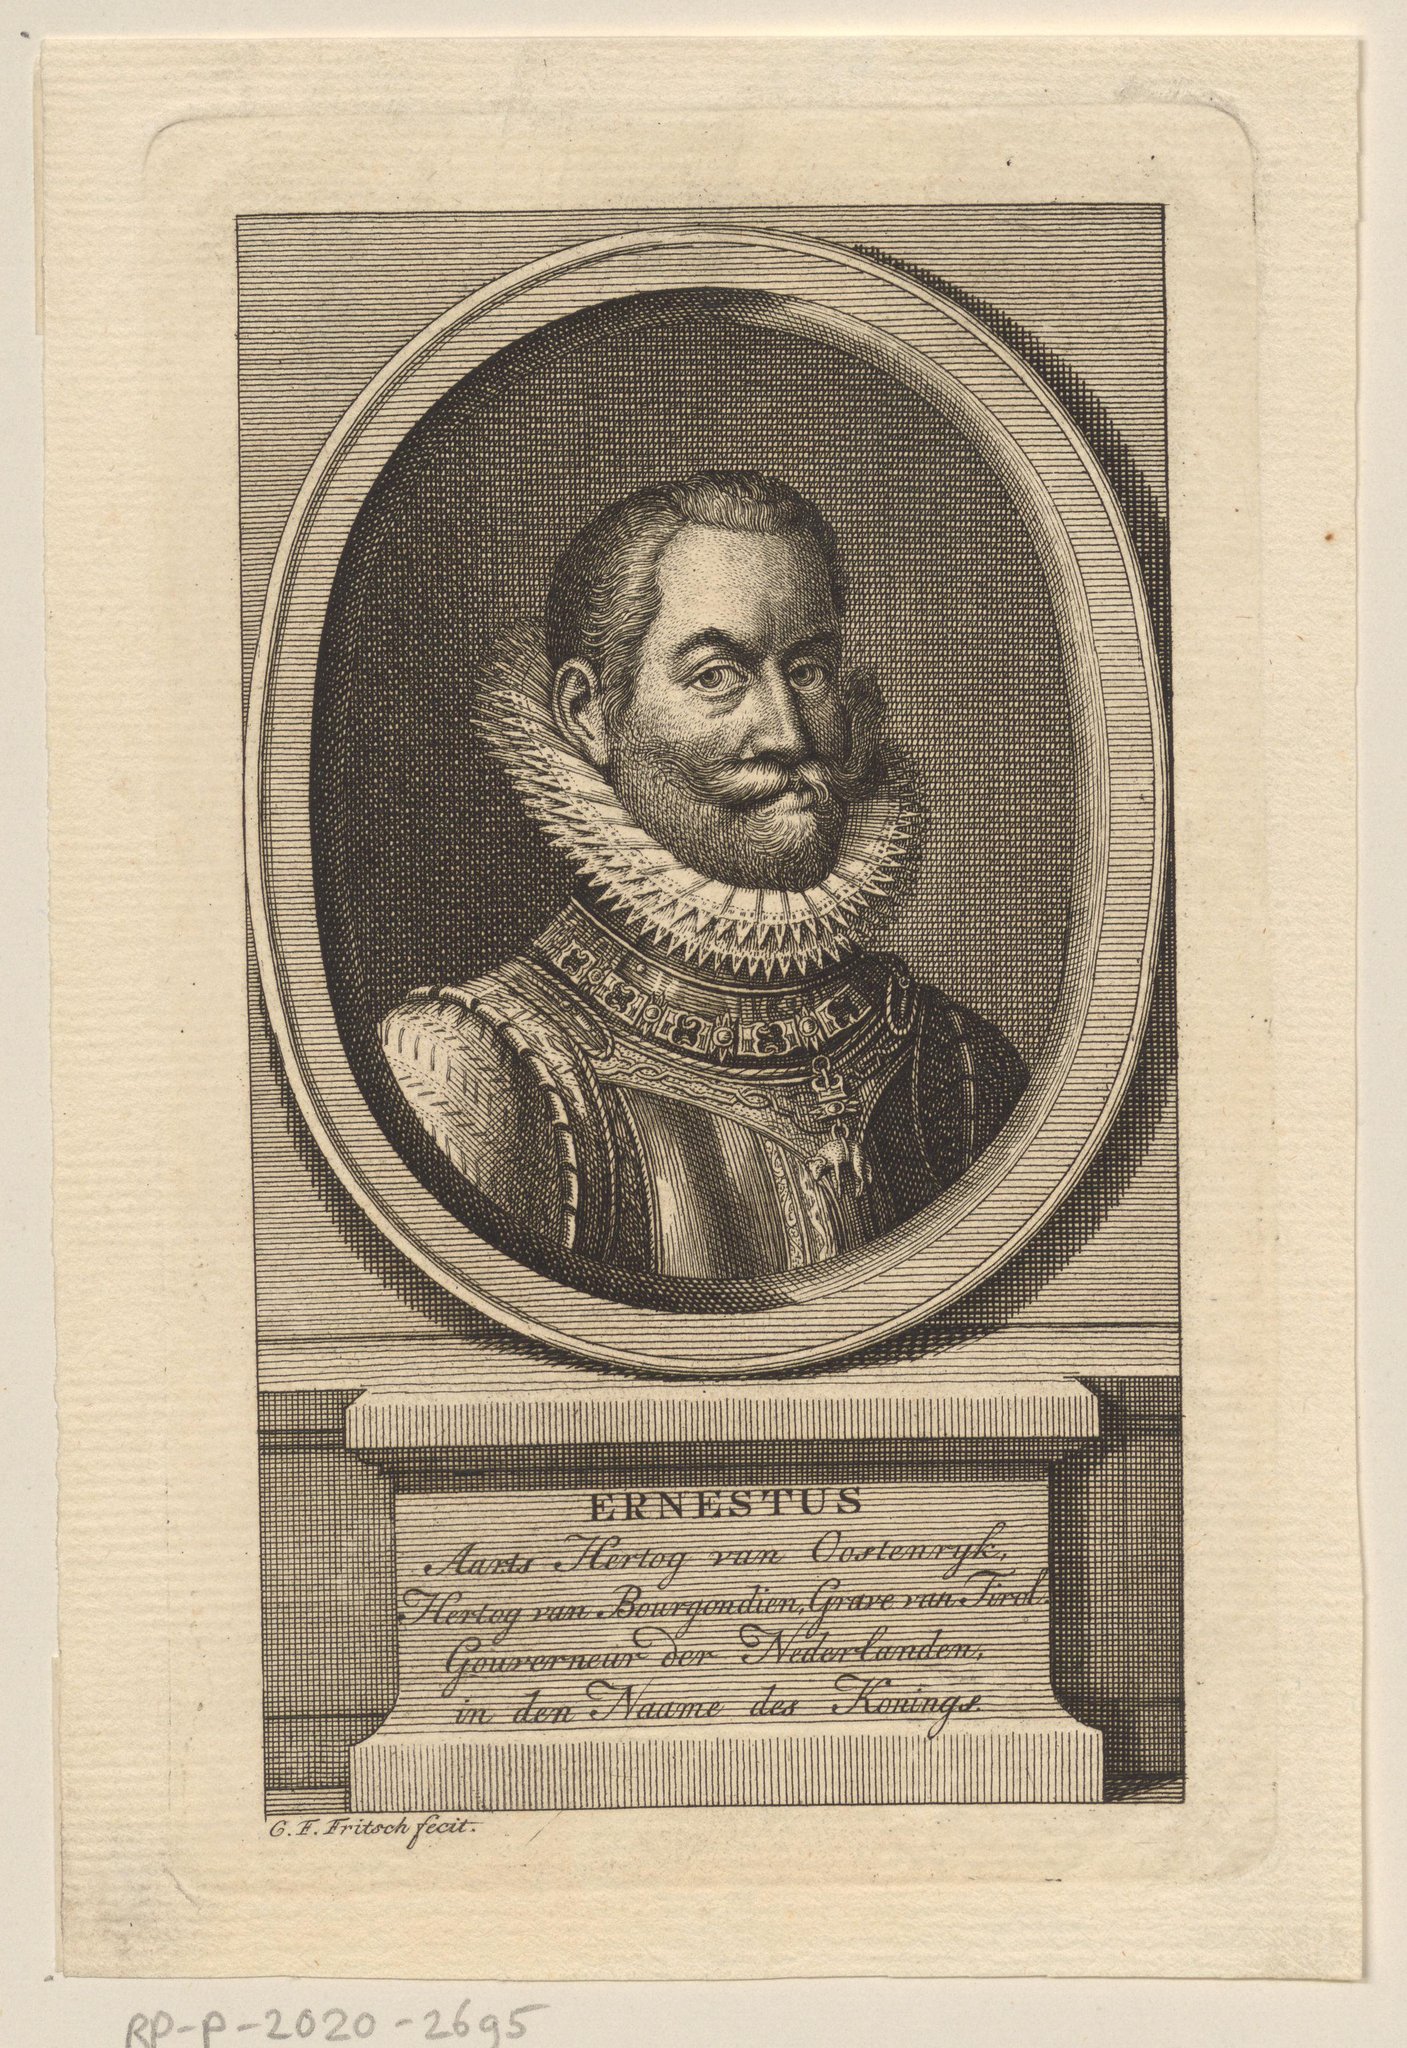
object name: book illustration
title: Portret van Ernst, aartshertog van Oostenrijk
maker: christian friedrich fritzsch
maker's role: print maker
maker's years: 1719-1774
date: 1786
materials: paper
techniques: engraving, etching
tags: vienna, historical persons, knighthood order of the golden fleece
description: Prent in deze staat waarschijnlijk uit: Meteren, Emanuel van. Historie van de oorlogen en geschiedenissen der Nederlanden, en der zelver Naburen: beginnende met den Jare 1315, en eindigende met den Jare 1611. Amsterdam: Steven Jacobus Baalde, 1786, dl. 6. Prent ook in eerdere edities van het werk gebruikt, tussen 1753 en 1774.